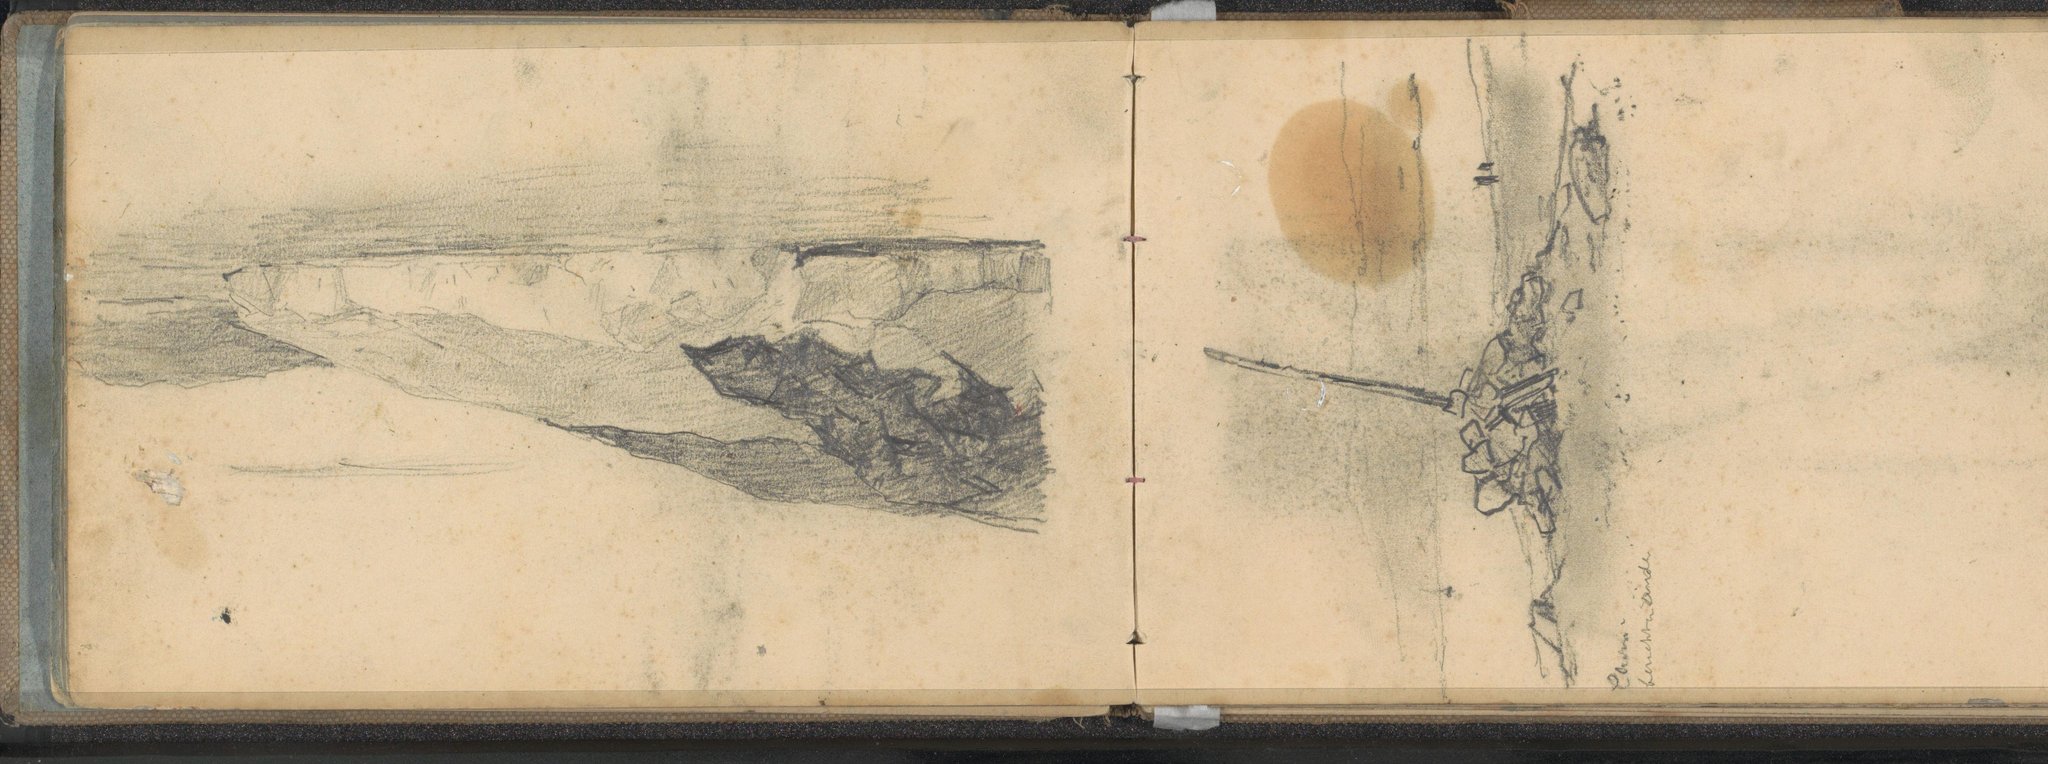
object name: sketchbook leaf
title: Kustgezicht, mogelijk Nova Zembla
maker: louis apol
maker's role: draughtsman, painter, print maker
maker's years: 1850-1936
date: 1880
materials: paper, pencil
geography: novaya zemlya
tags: coast (in polar regions)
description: Blad 15 verso uit een schetsboek met 35 bladen betekend tijdens de expeditie naar Nova Zembla in 1880.